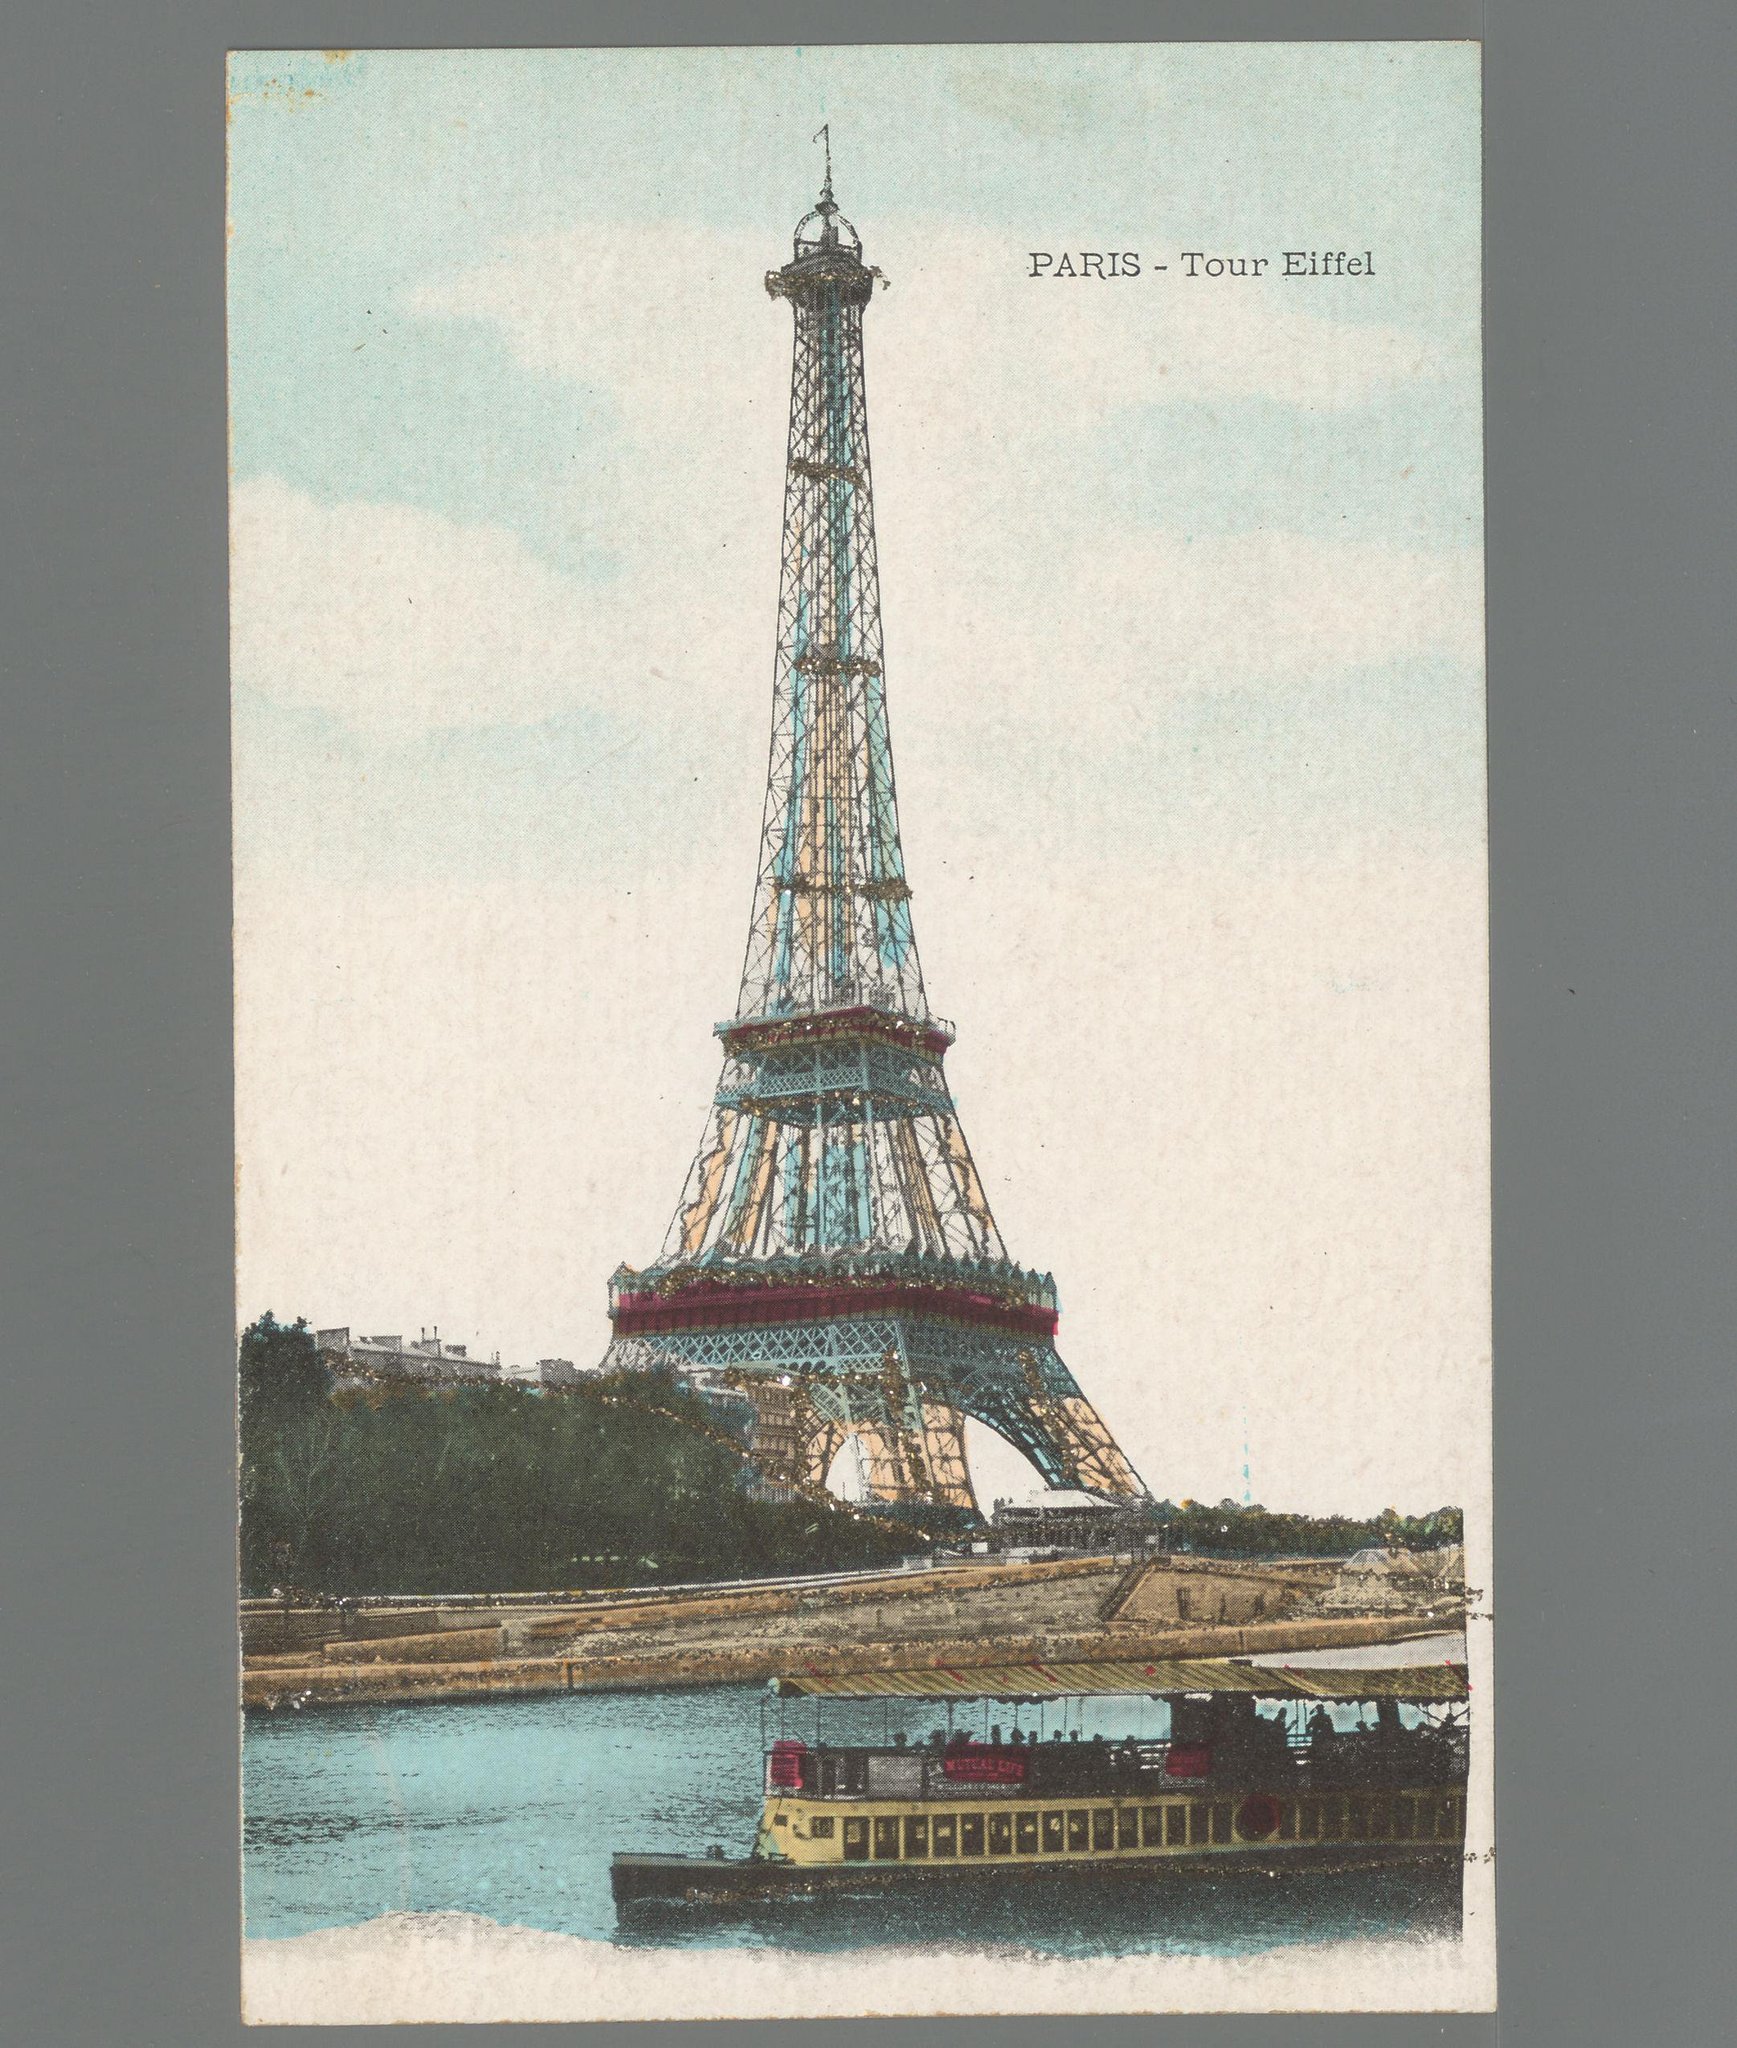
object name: photomechanical print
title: Paris. Tour Eiffel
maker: Anonymous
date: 1904-1906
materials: cardboard, glitter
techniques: hand coloring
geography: paris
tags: river, ships (in general), tower, clock tower ~ monumental adornment (+ city(-scape) with figures, staffage), eiffel tower